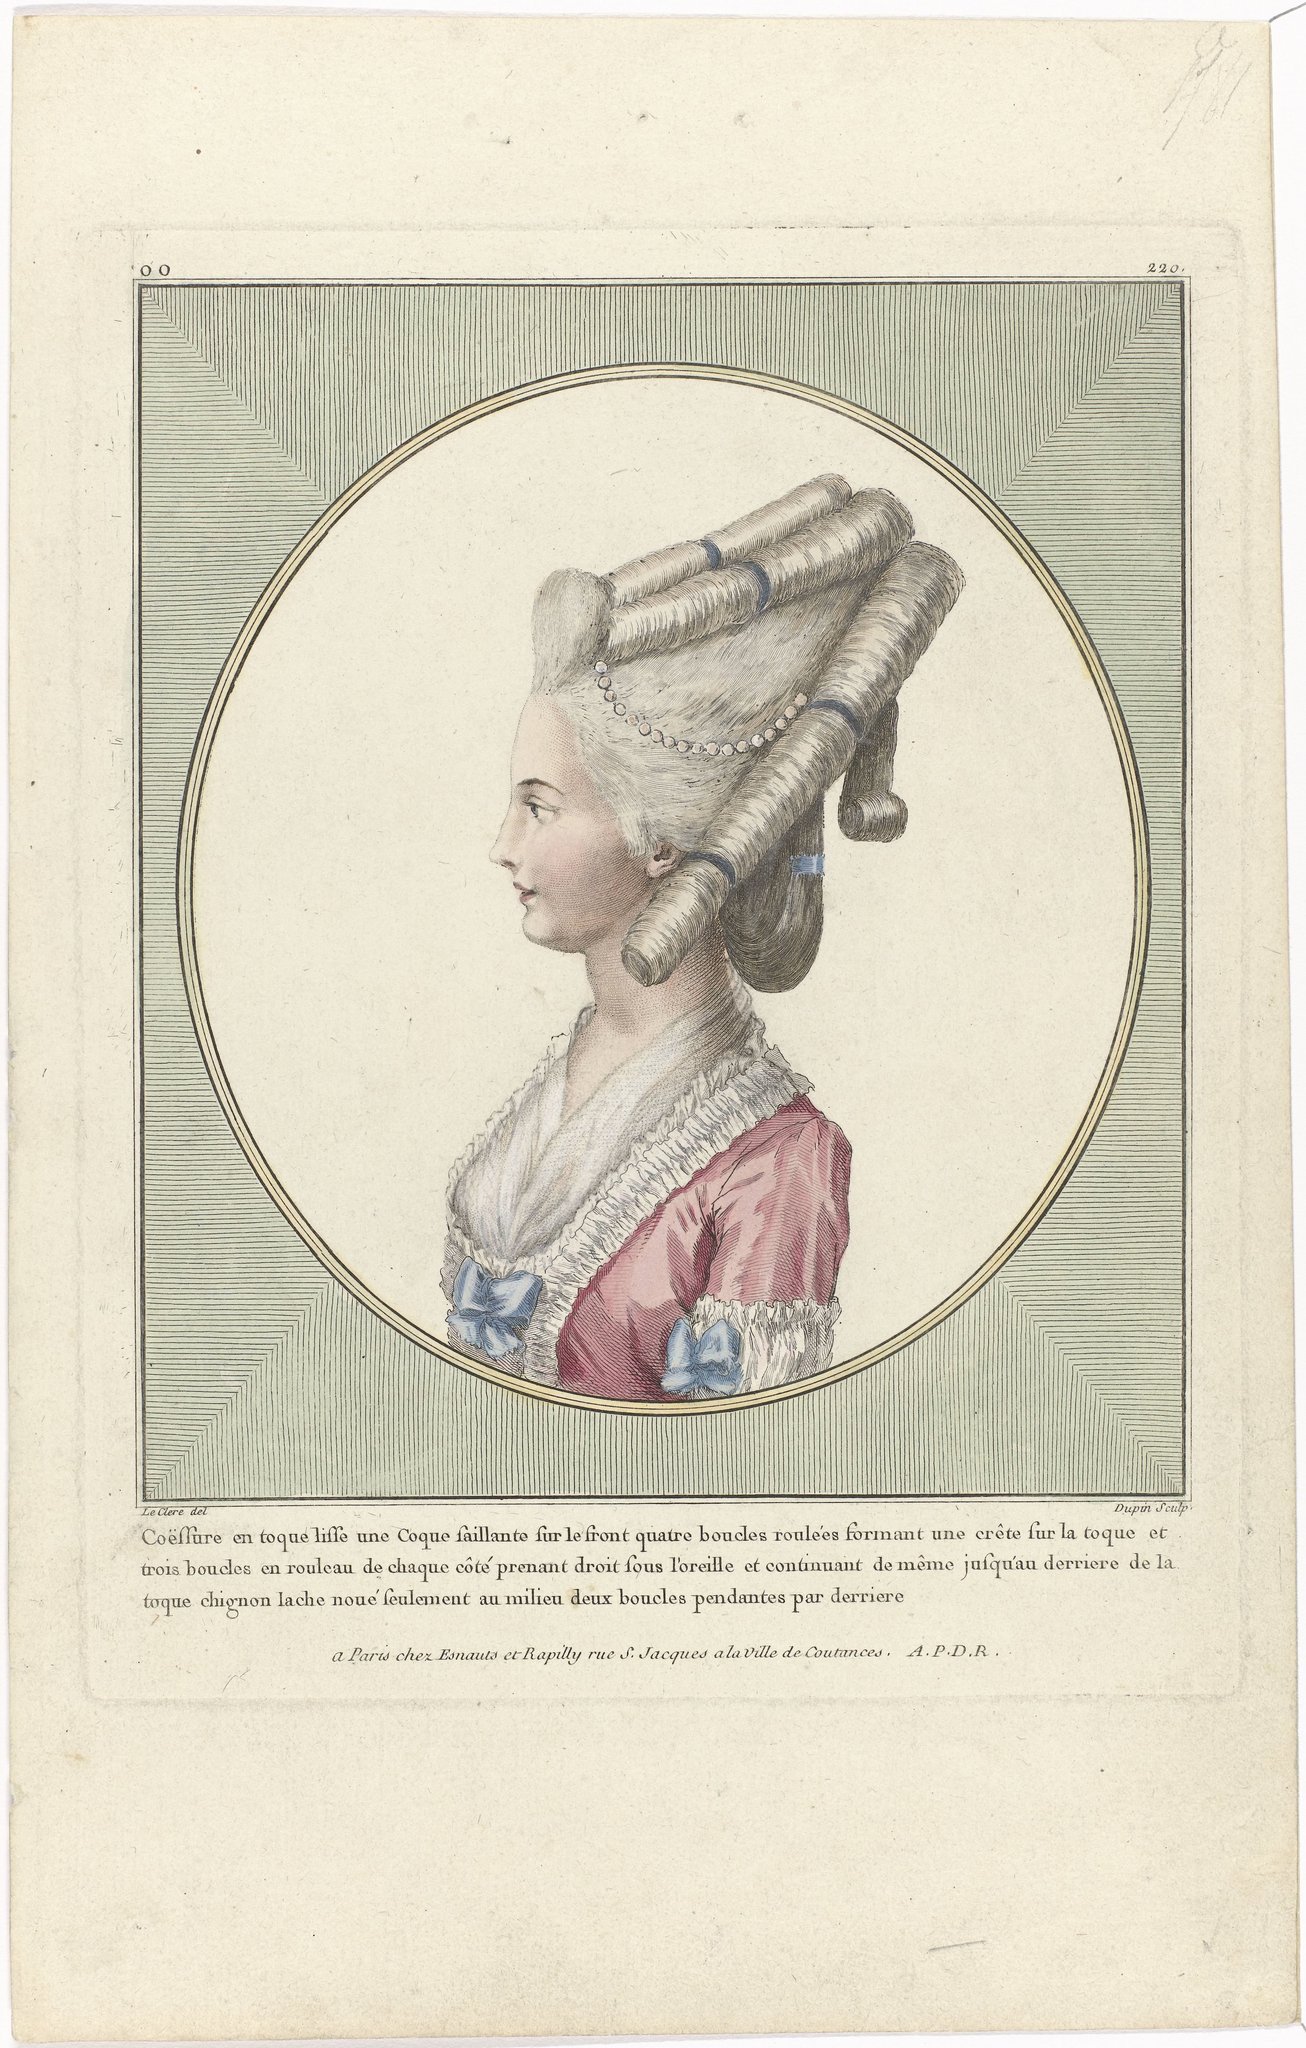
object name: fashion print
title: Coiffures, Poufs, Hats and Bonnets: Eleven Coiffures and Headdresses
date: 1781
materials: paper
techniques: engraving, hand coloring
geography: paris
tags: clothing for the upper part of the body (+ women's clothes), styles of hairdress - aa - ~ women, fashion plates, piece of clothing covering the breast or décolleté (fichu) (+ women's clothes)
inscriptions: address: ‘A Paris chez Esnauts et Rapilly rue S. Jacques a la Ville de Coutances. A.P.D.R.’, caption: ‘Coëffure en toque lisse une Coque saillante sur le front quatre boucles roulées formant une crête sur la toque et trois boucles en rouleau de chaque côté prenant droit sous l'oreille et continuant de même jusqu'au derrriere de la toque chignon lache noué seulement au milieu deux boucles pendantes par derriere.’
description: Ladies’ hairstyles were ingenious works of art, built around a core of cushions and horsehair. Hair was piled high in curls and twists (chignons) and adorned with feathers, ribbons, artificial flowers, tulle and jewels to create various fancifully named poufs. Because the hair was dressed using animal fat and powdered with wheat flour, these poufs attracted all manner of insects. Far from hygienic, they moreover did not last long. When they went out, ladies protected their hairdos with a voluminous ribbed hood called a calèche 1. Hairdressers of the time, who styled themselves as artists, used prints to advertise their latest creations and craftsmanship 2 3.